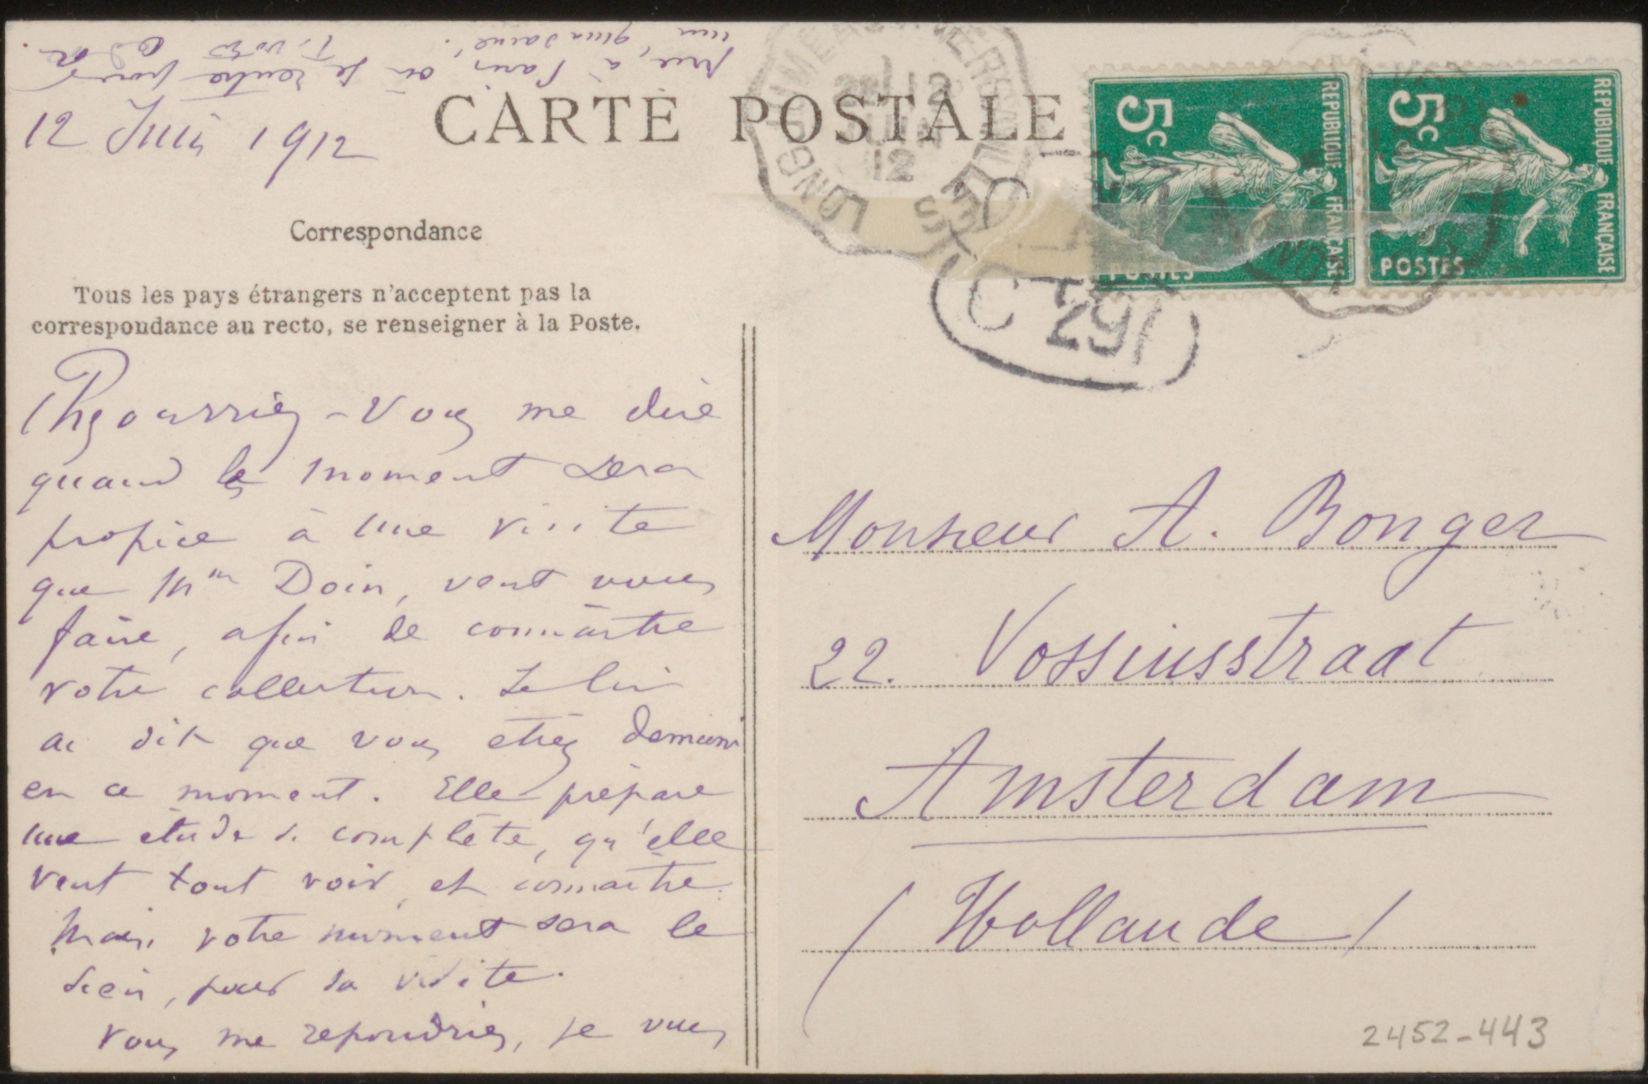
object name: ansichtkaart, prentbriefkaart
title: Prentbriefkaart aan Andries Bonger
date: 1912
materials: cardboard, ink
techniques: photograph, pen, writing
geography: longjumeau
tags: amsterdam, andries bonger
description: Prentbriefkaart behoort tot een album samengesteld door weduwe Françoise W.M. Barones van der Borch van Verwolde met afschriften van brieven met betrekking tot (de familie van) Odilon Redon. De prentbriefkaart werd bewaard op pagina 191.